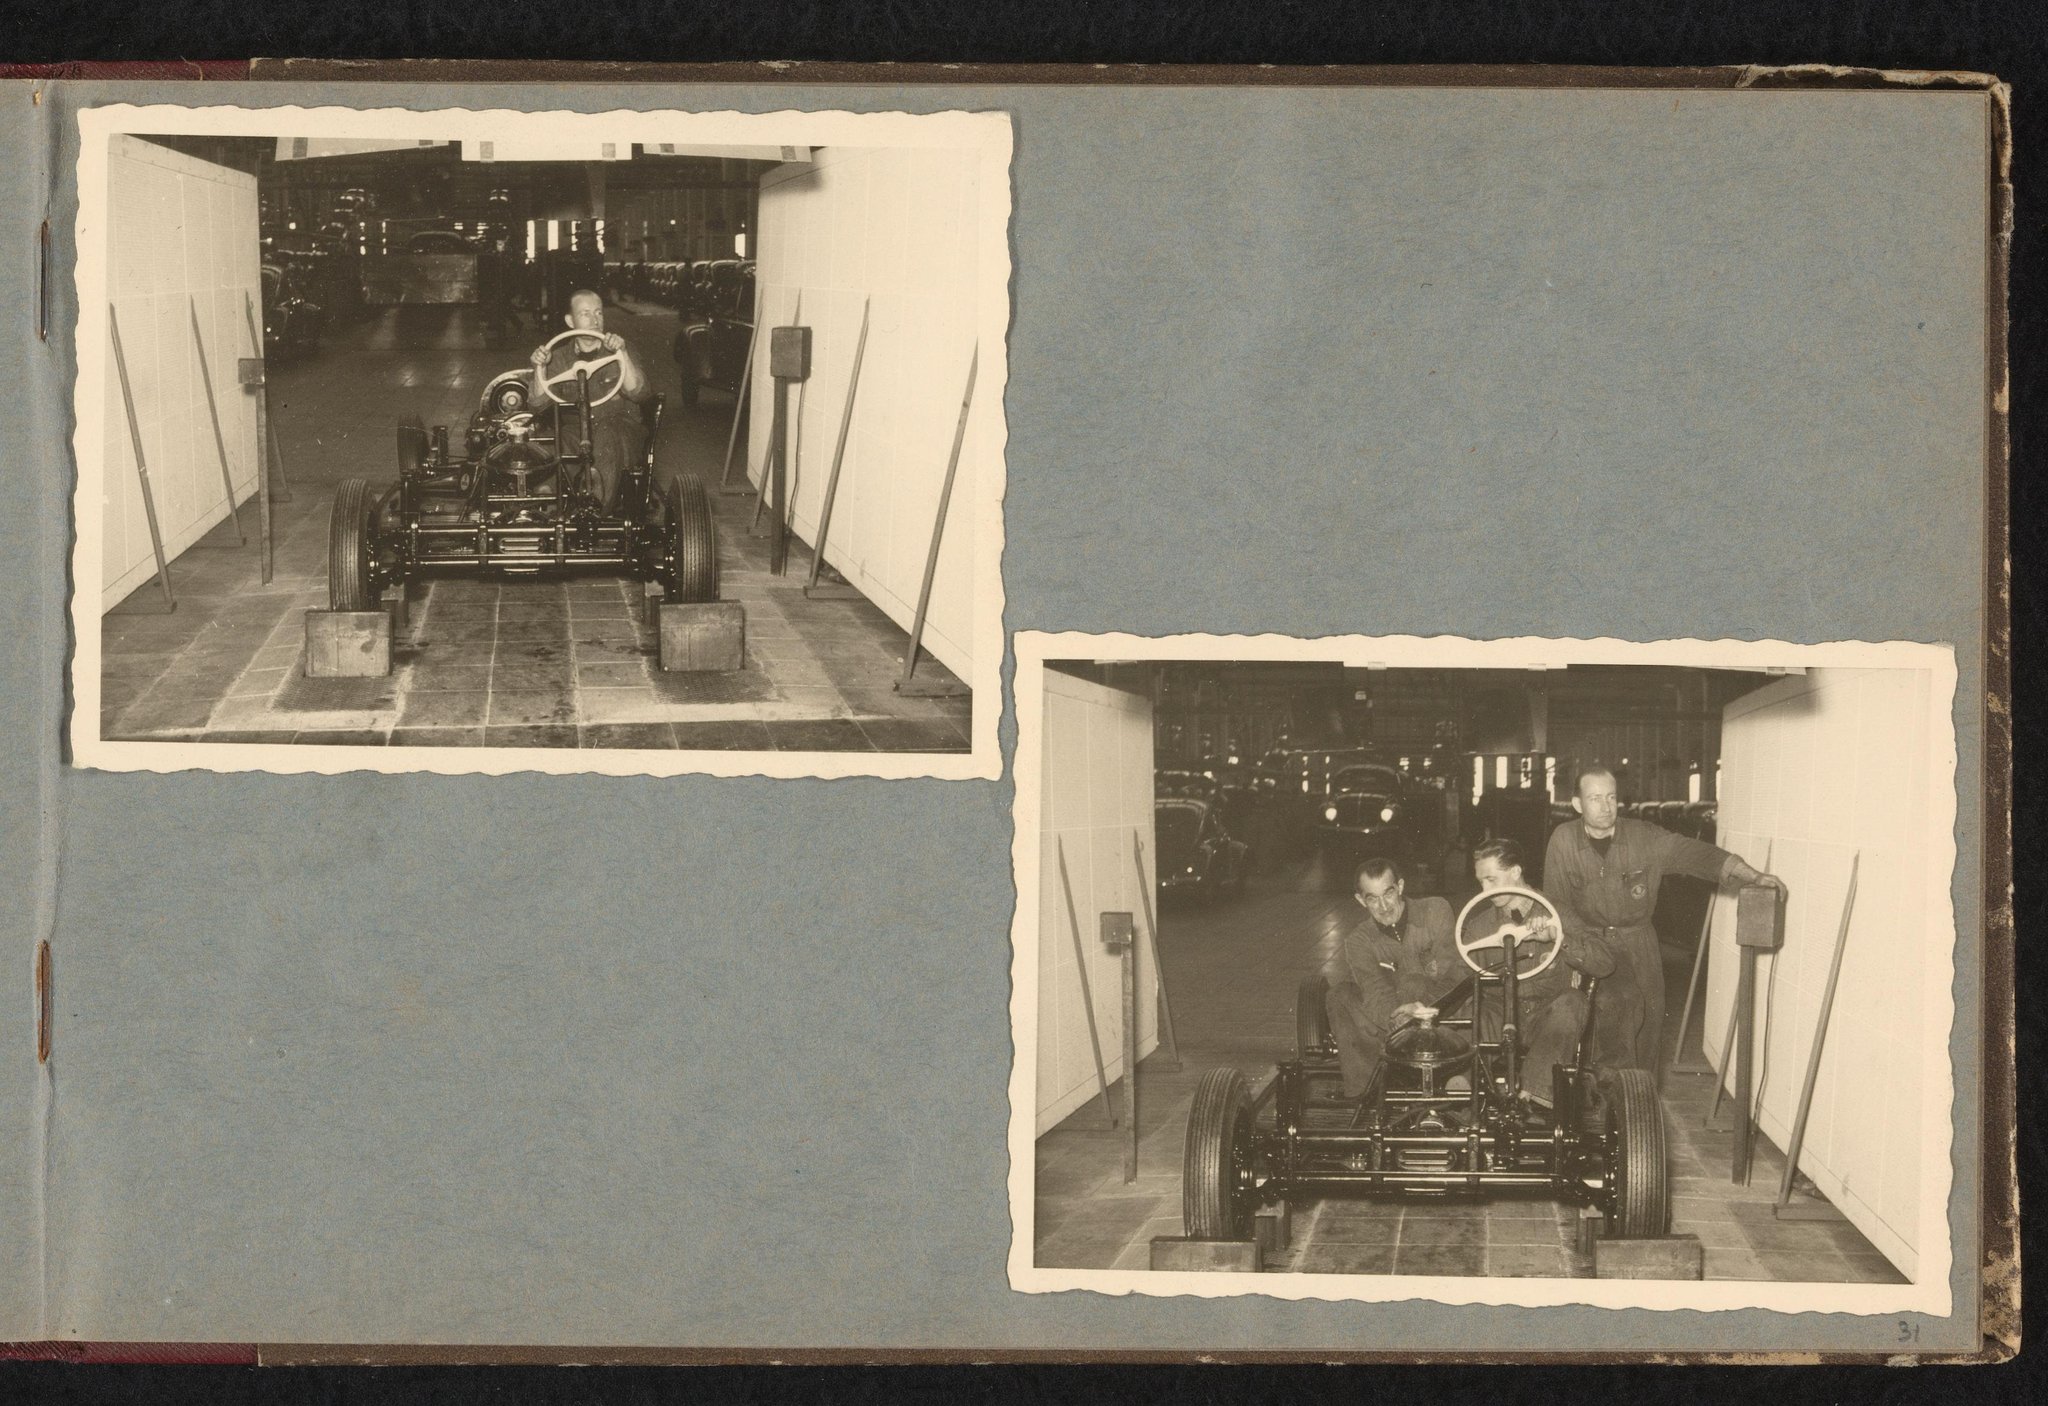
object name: photograph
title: Volkswagenfabriek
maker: Anonymous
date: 1945-1955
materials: paper, photographic support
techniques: gelatin silver print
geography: germany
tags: factory-interior, machine shop, automobile, germany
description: Albumblad met twee foto's van werknemers, met Glitsch als voorman, in een Volkswagenfabriek na de oorlog Onderdeel van een fotoalbum over de diensttijd van Dieter Glitsch uit Hardegsen tijdens de Tweede Wereldoorlog en de jaren daarna.